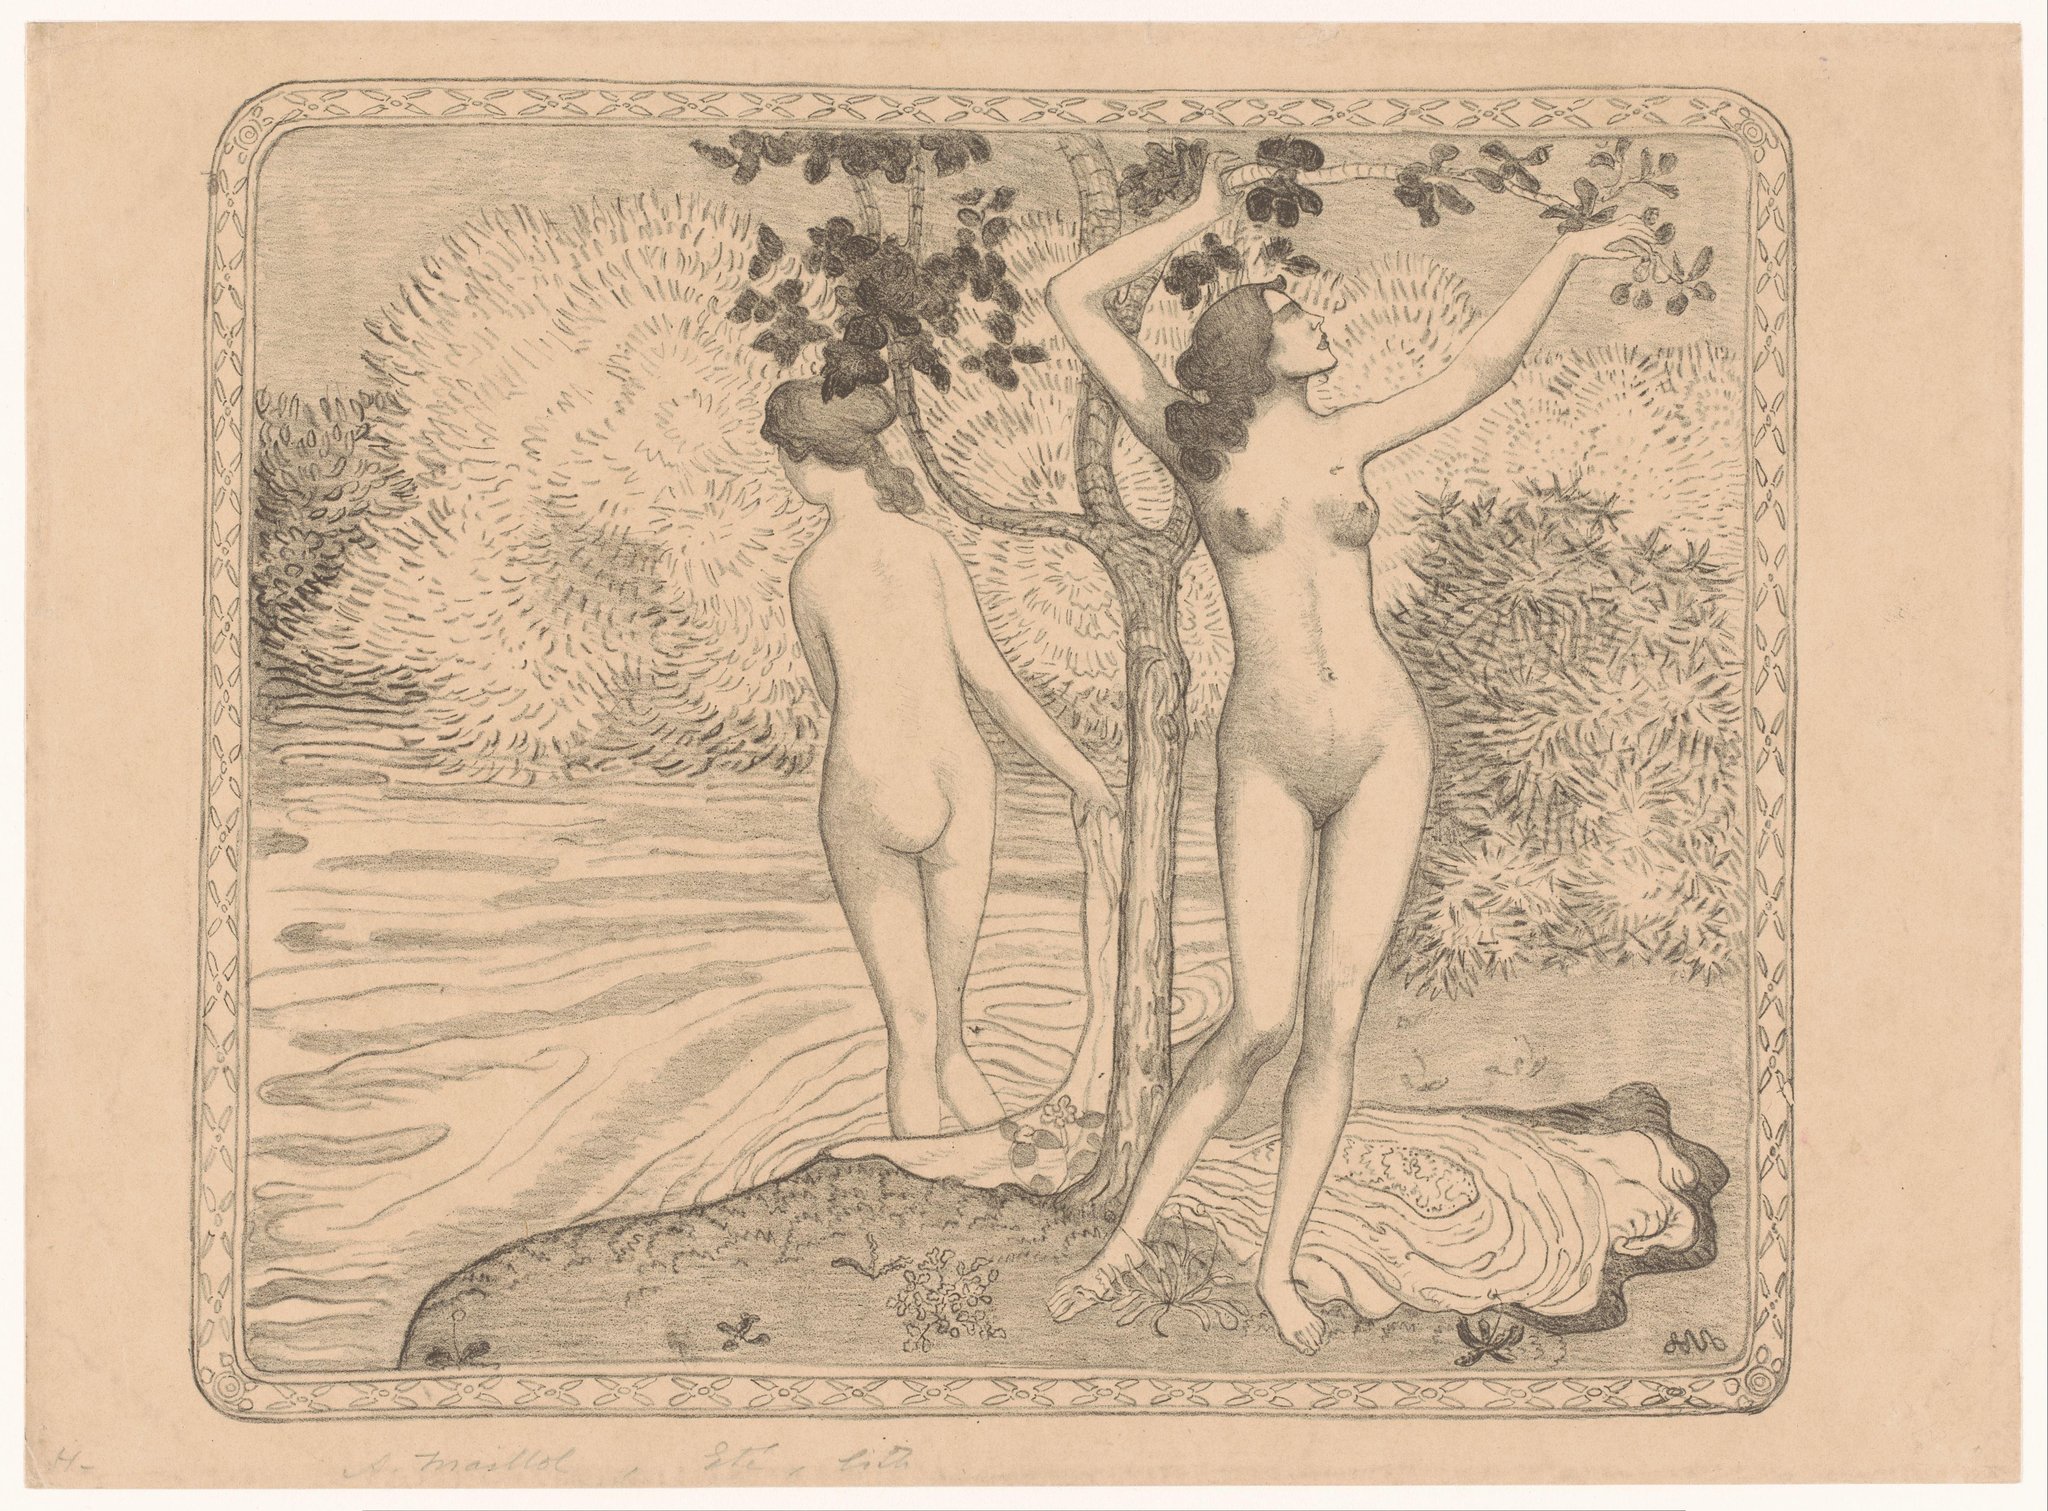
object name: print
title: Twee badende vrouwen onder een boom aan de waterkant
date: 1895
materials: paper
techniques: lithography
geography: paris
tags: standing figure - aa - female human figure, lake - hh - ideal landscapes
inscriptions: collector's mark: Lugt 2228, collector's mark: Lugt 2760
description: Prent ook verschenen in: L'Epreuve, nr. 3, 1895, pl. 6.